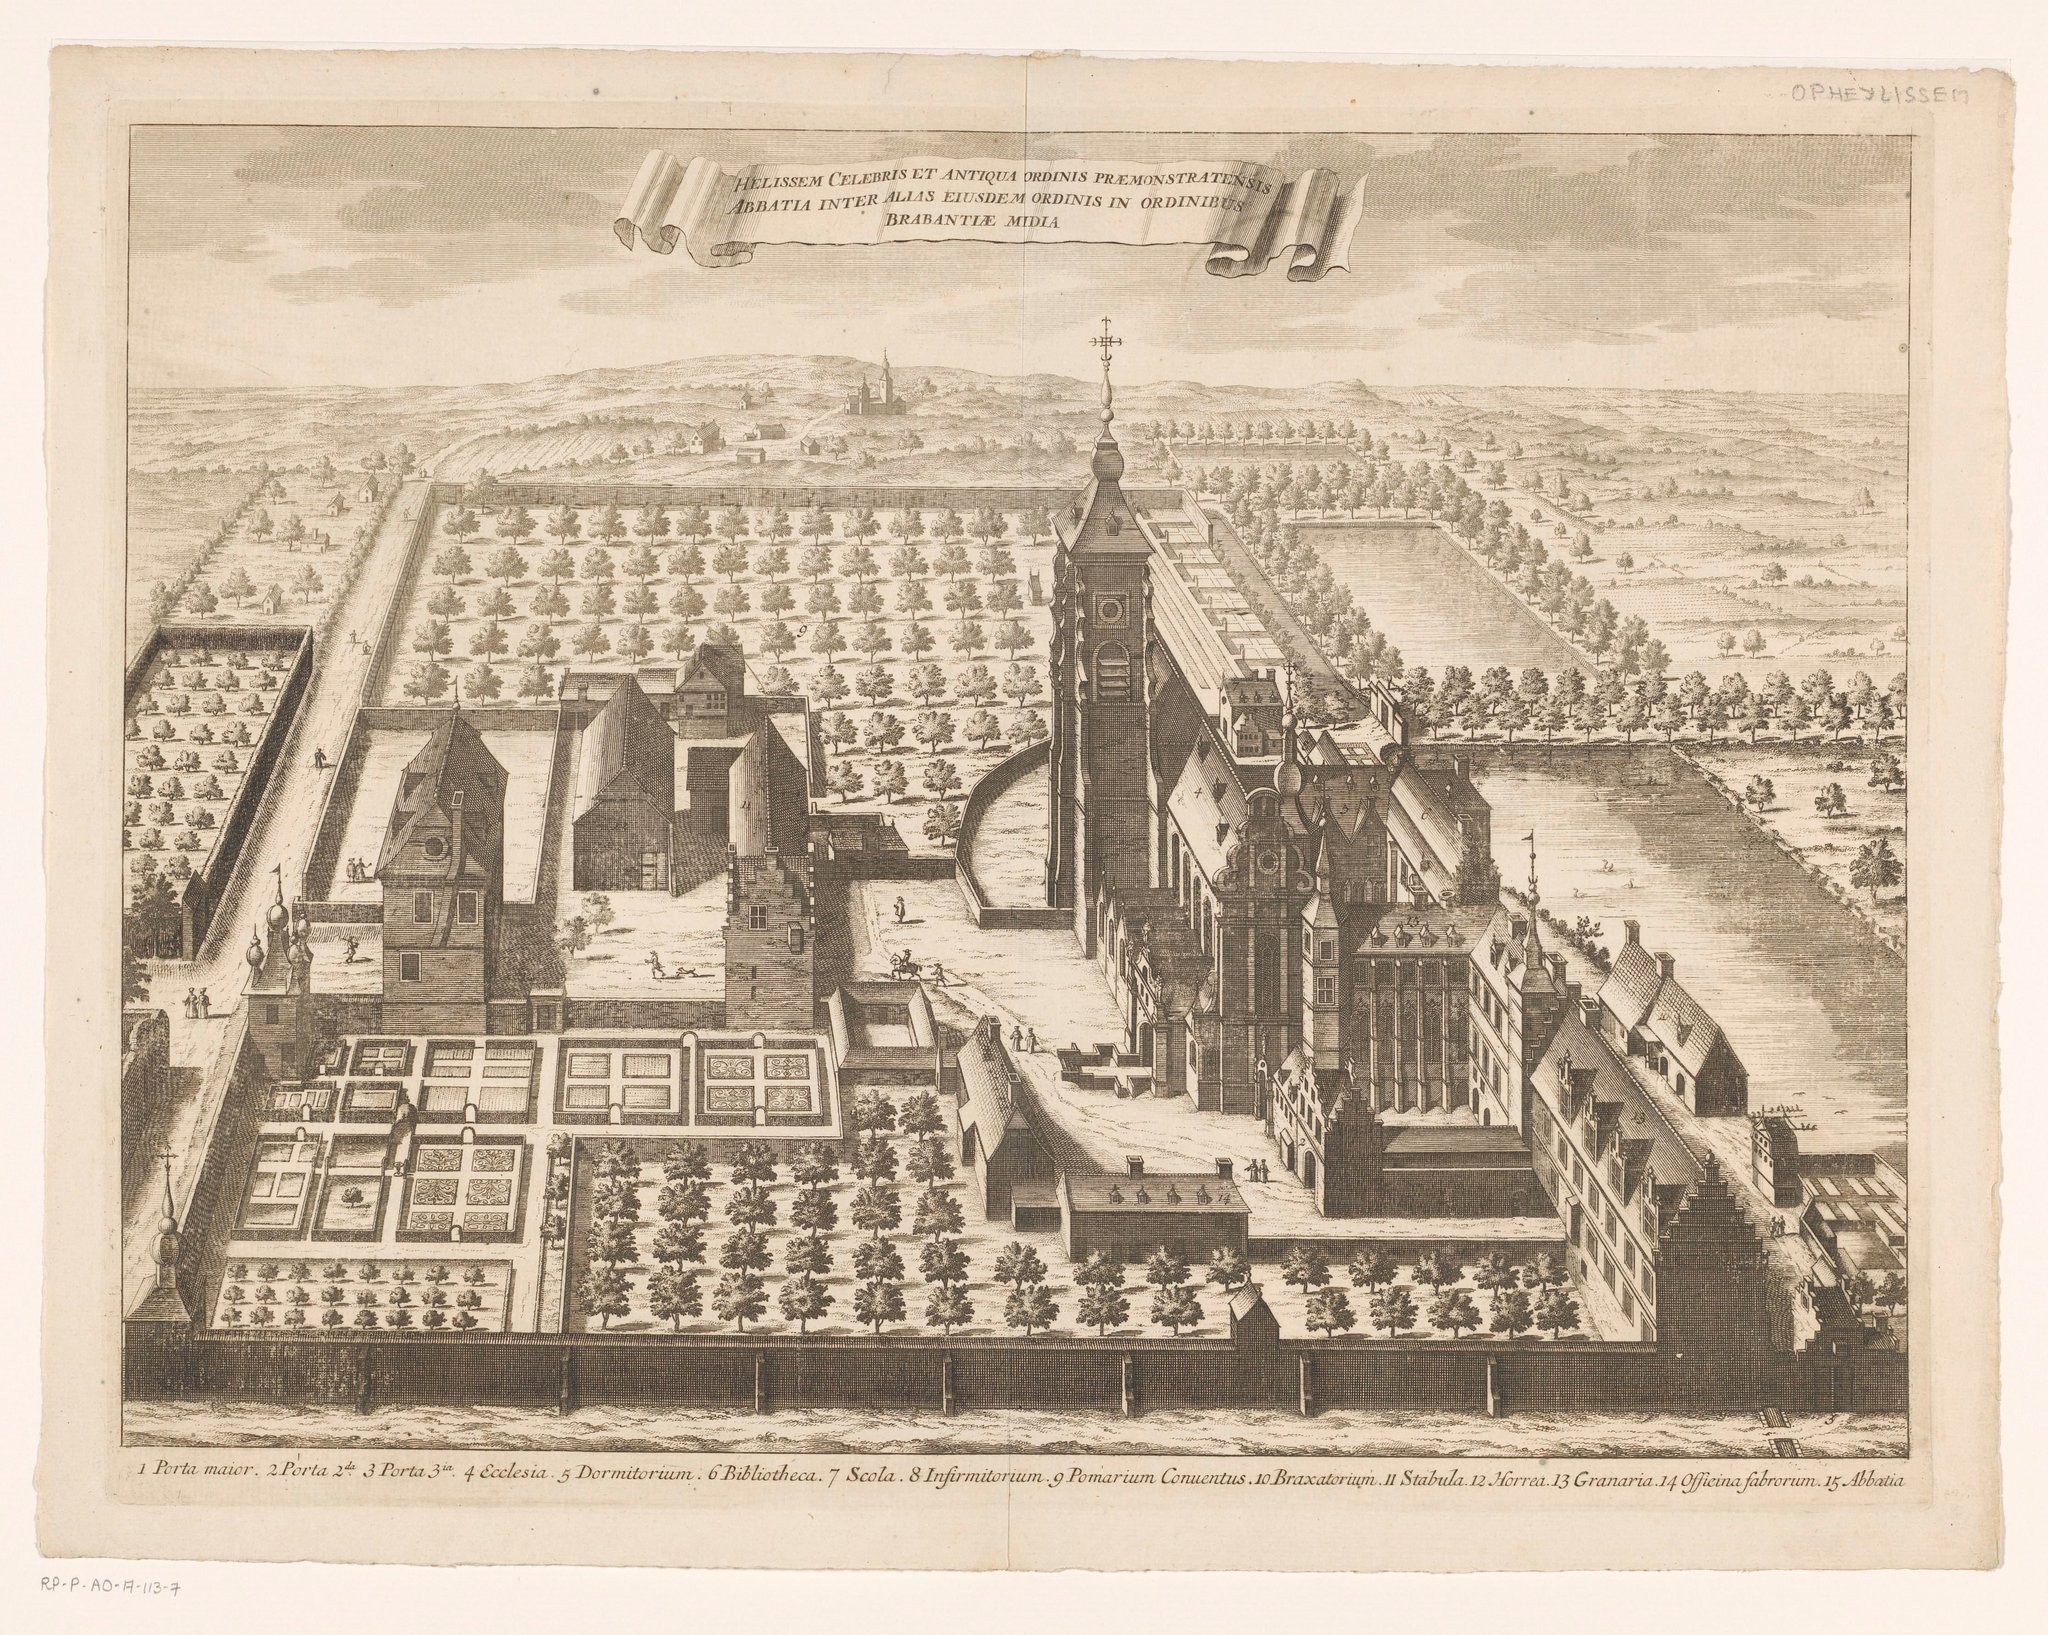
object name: book illustration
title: Gezicht op de Abdij van Heylissem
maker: Anonymous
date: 1726-1734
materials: paper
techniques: etching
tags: abbey, monastery, convent ~ roman catholic church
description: Prent ook gebruikt in: Sanderus, Antonius. Groot kerkelyk toneel des Hertogdoms van Brabant (...). Den Haag: Christiaan van Lom, 1727. En in: Sanderus, Antonius. Antonii Sanderi presbyteri Chorographia sacra Brabantiæ. 3 delen. Den Haag: Christiaan van Lom, 1726-1727. En in: Sanderus, Antonius. Le grand theatre sacré du duché de Brabant (...). 4 delen. Den Haag: Gerard Block, 1729-1734.